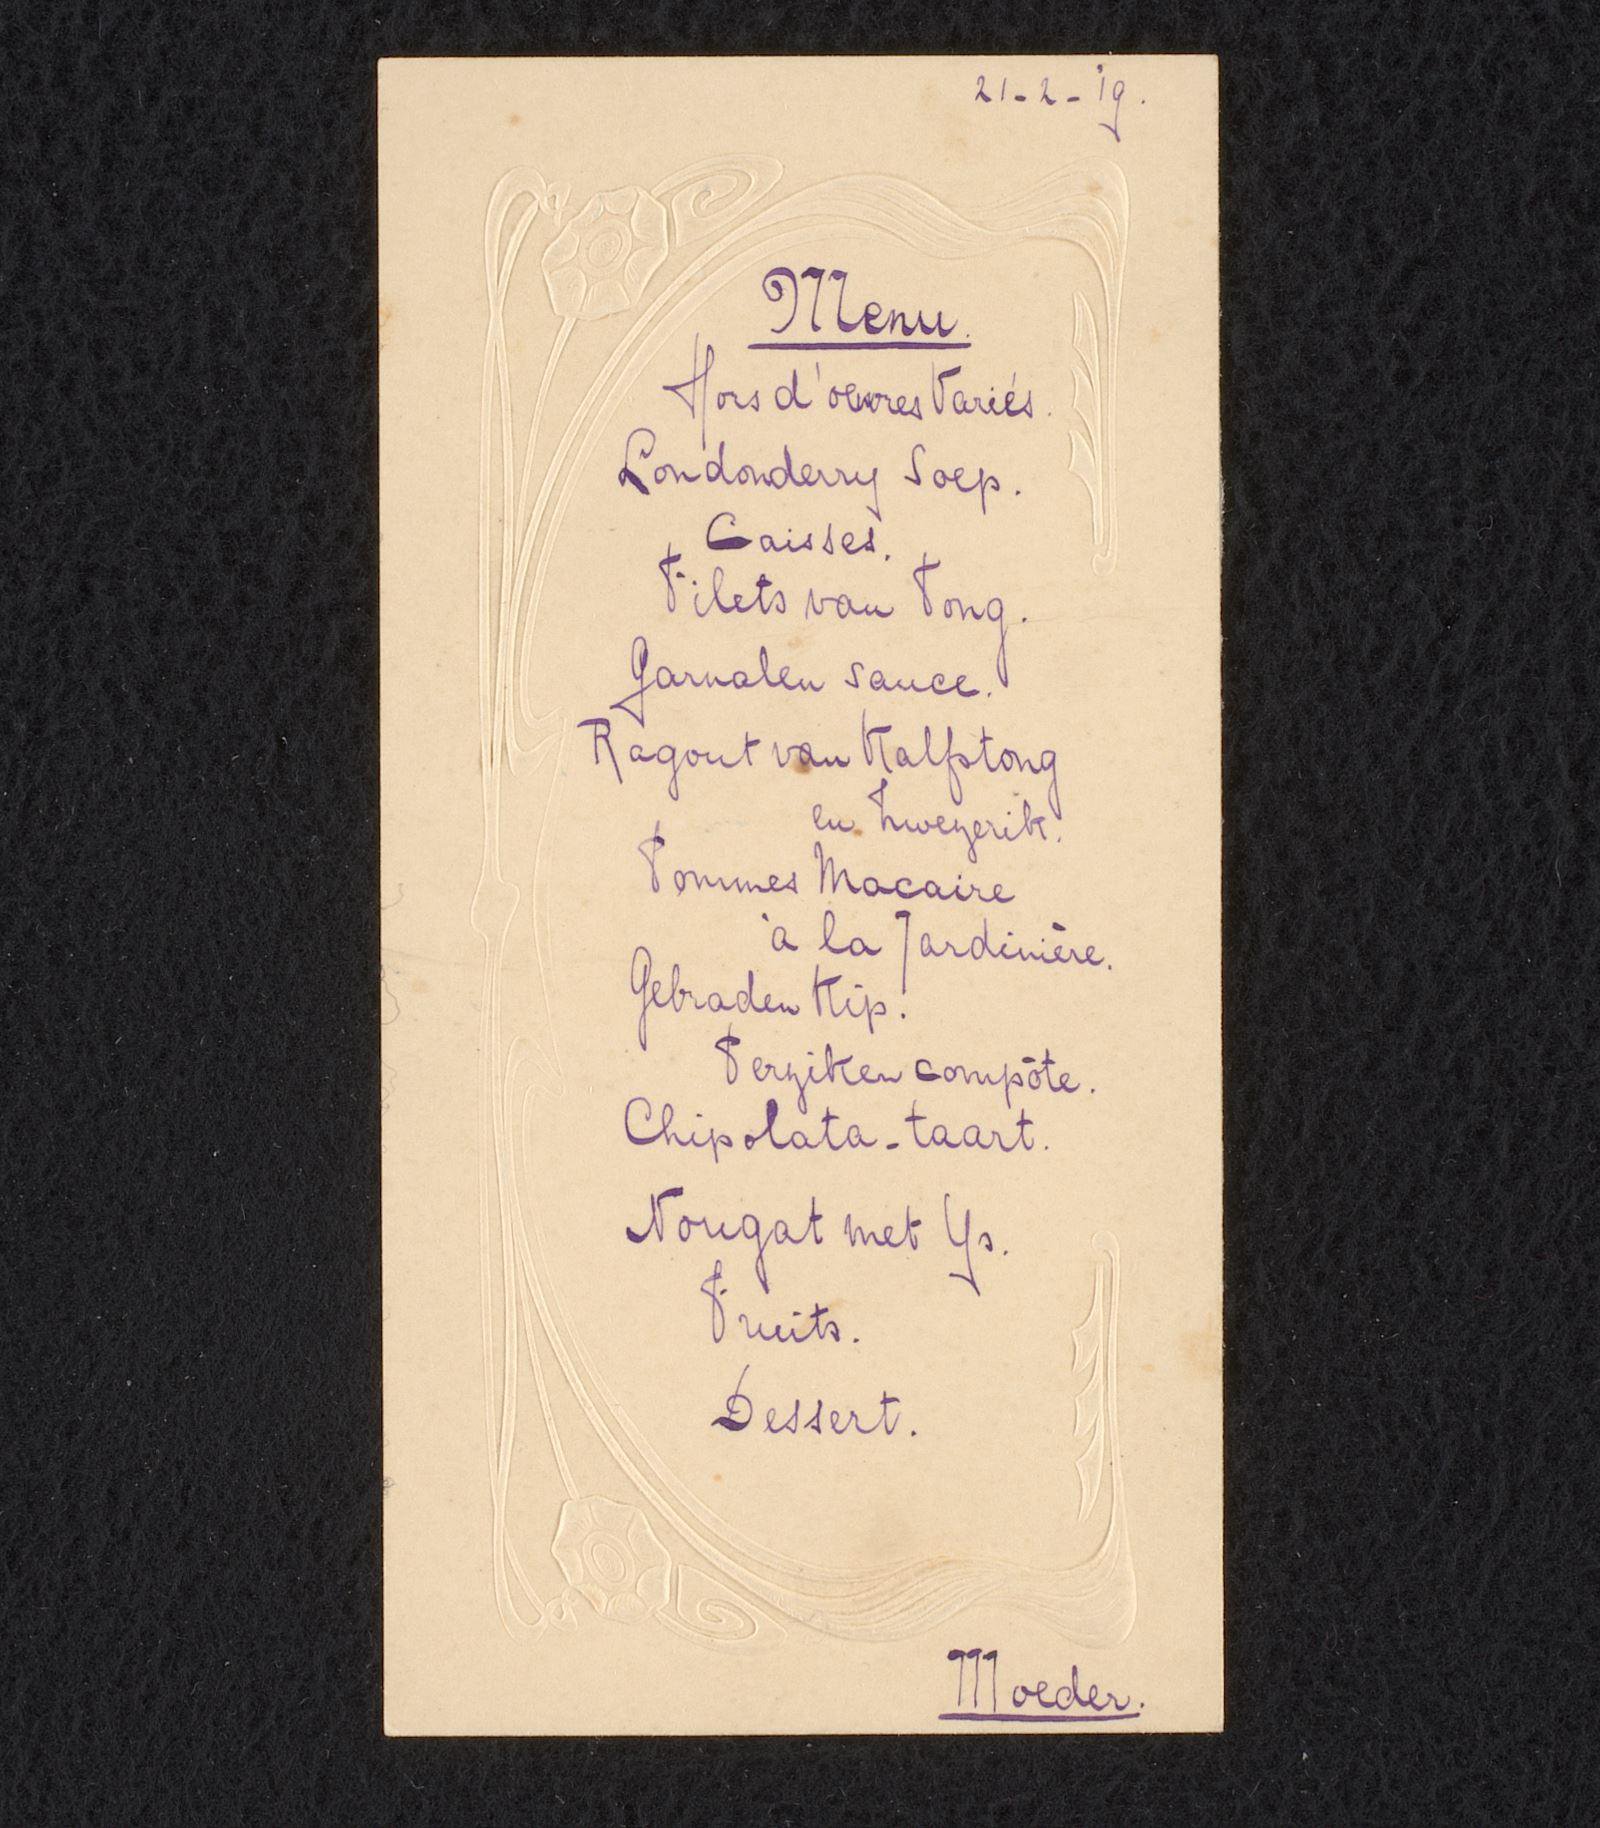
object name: menu, menukaart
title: Menukaart voor een diner op 21 februari 1919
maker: Anonymous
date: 1919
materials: paper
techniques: blind stamped, pen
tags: 43b311(+12)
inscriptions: collector's mark: Lugt 2228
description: Bij gebrek aan gegevens over de vervaardiger is voor de bepaling van de rechten van dit object gebruik gemaakt van de vervaardigingsdatum.